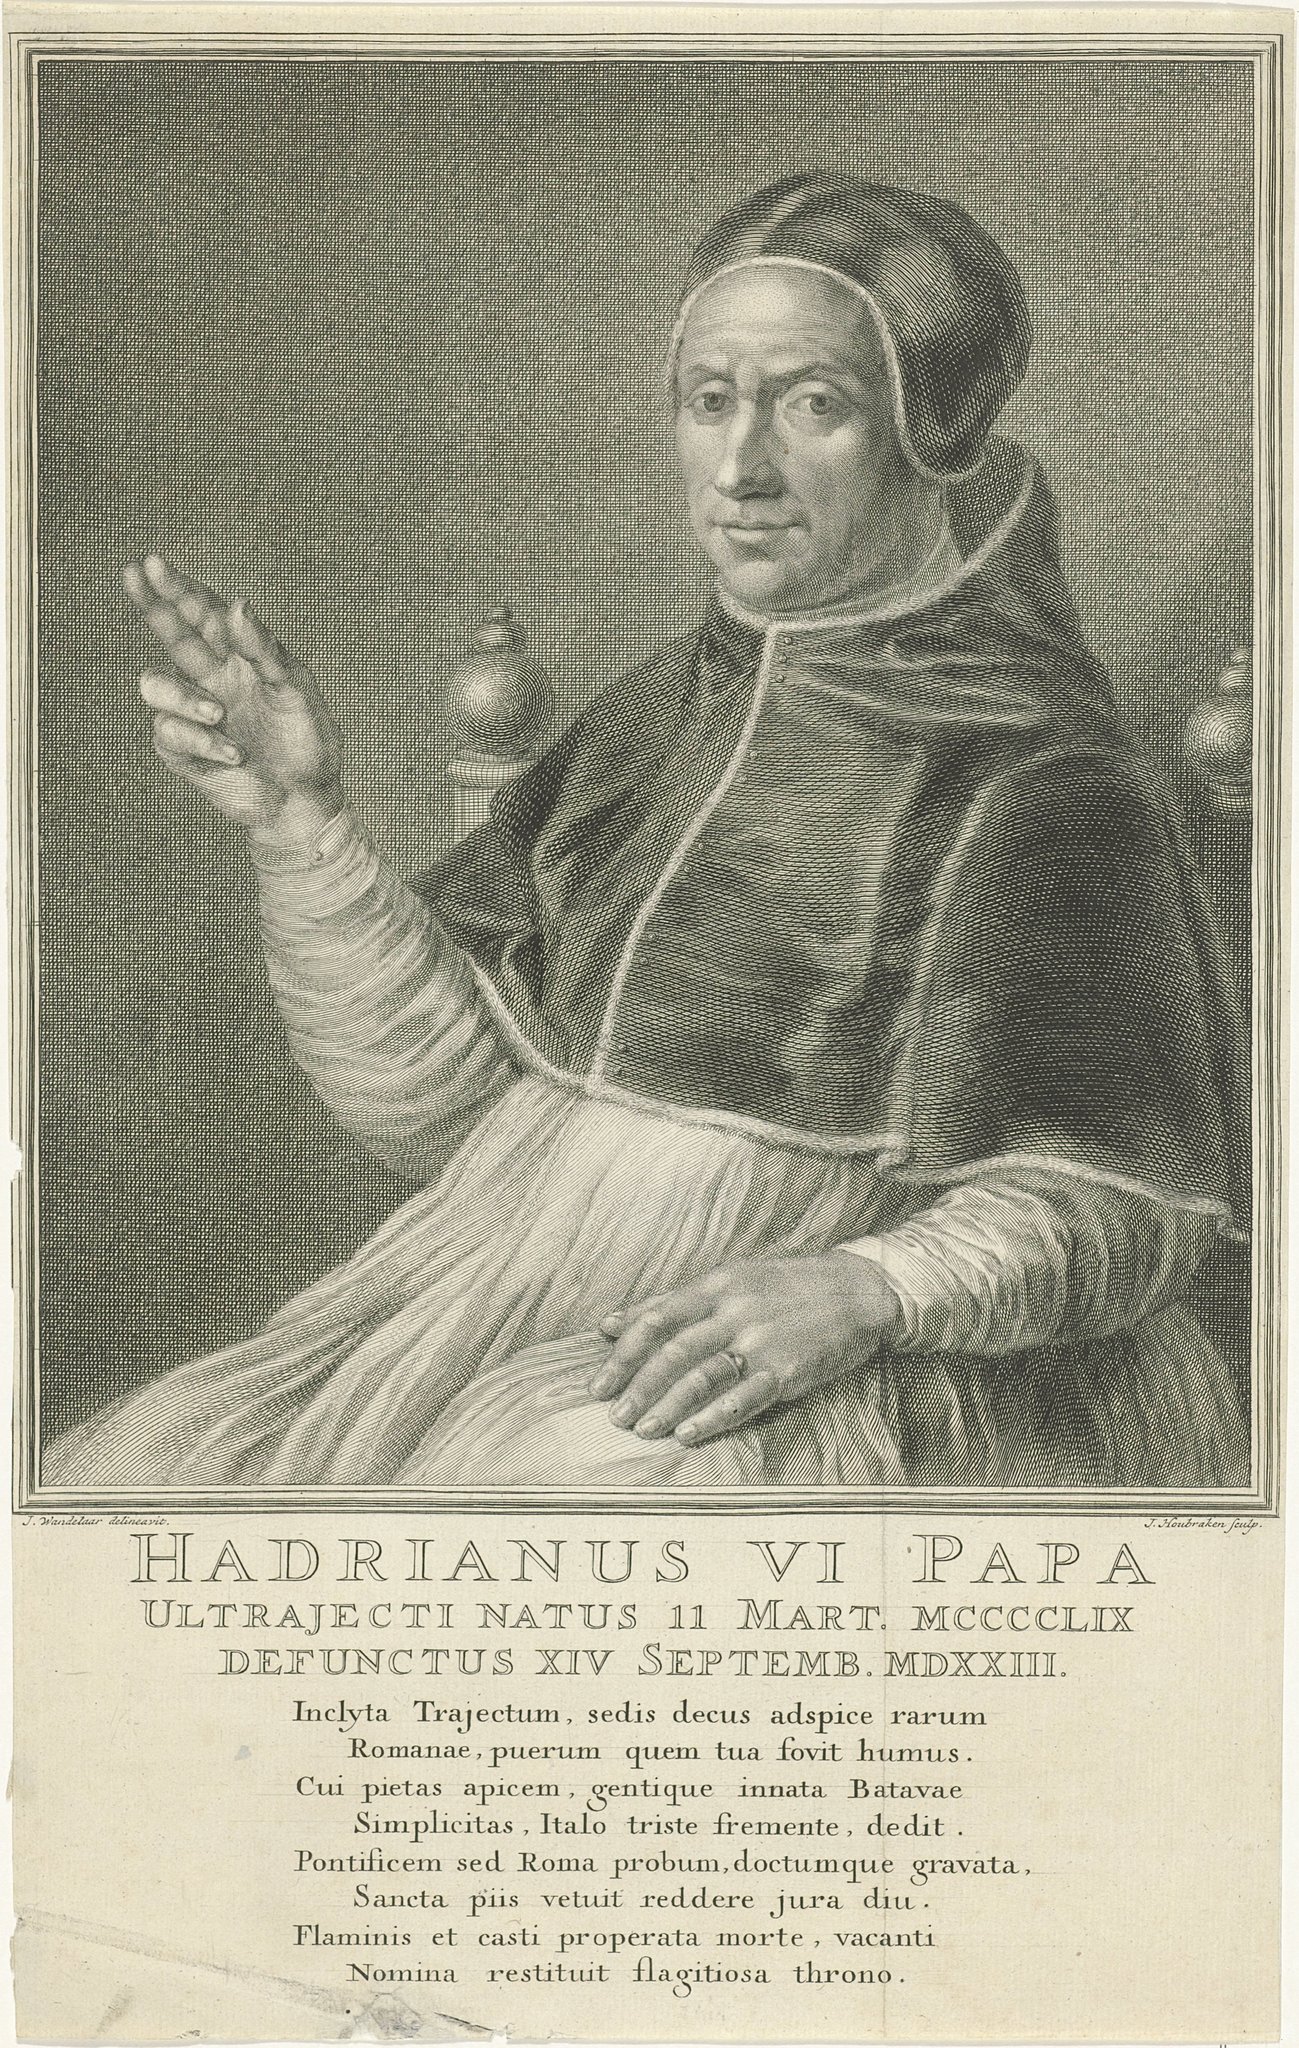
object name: print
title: Hadrianus VI Papa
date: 1708-1780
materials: paper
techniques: engraving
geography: amsterdam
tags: utrecht, rome, clergyman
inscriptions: collector's mark: Lugt 2228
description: Kniestuk van paus Adrianus VI naar links, zittend in een stoel. Met zijn rechterhand maakt hij een zegenend gebaar. Onder het portret zijn naam en gegevens in drie regels in het Latijn en daaronder een achtregelige tekst in het Latijn.